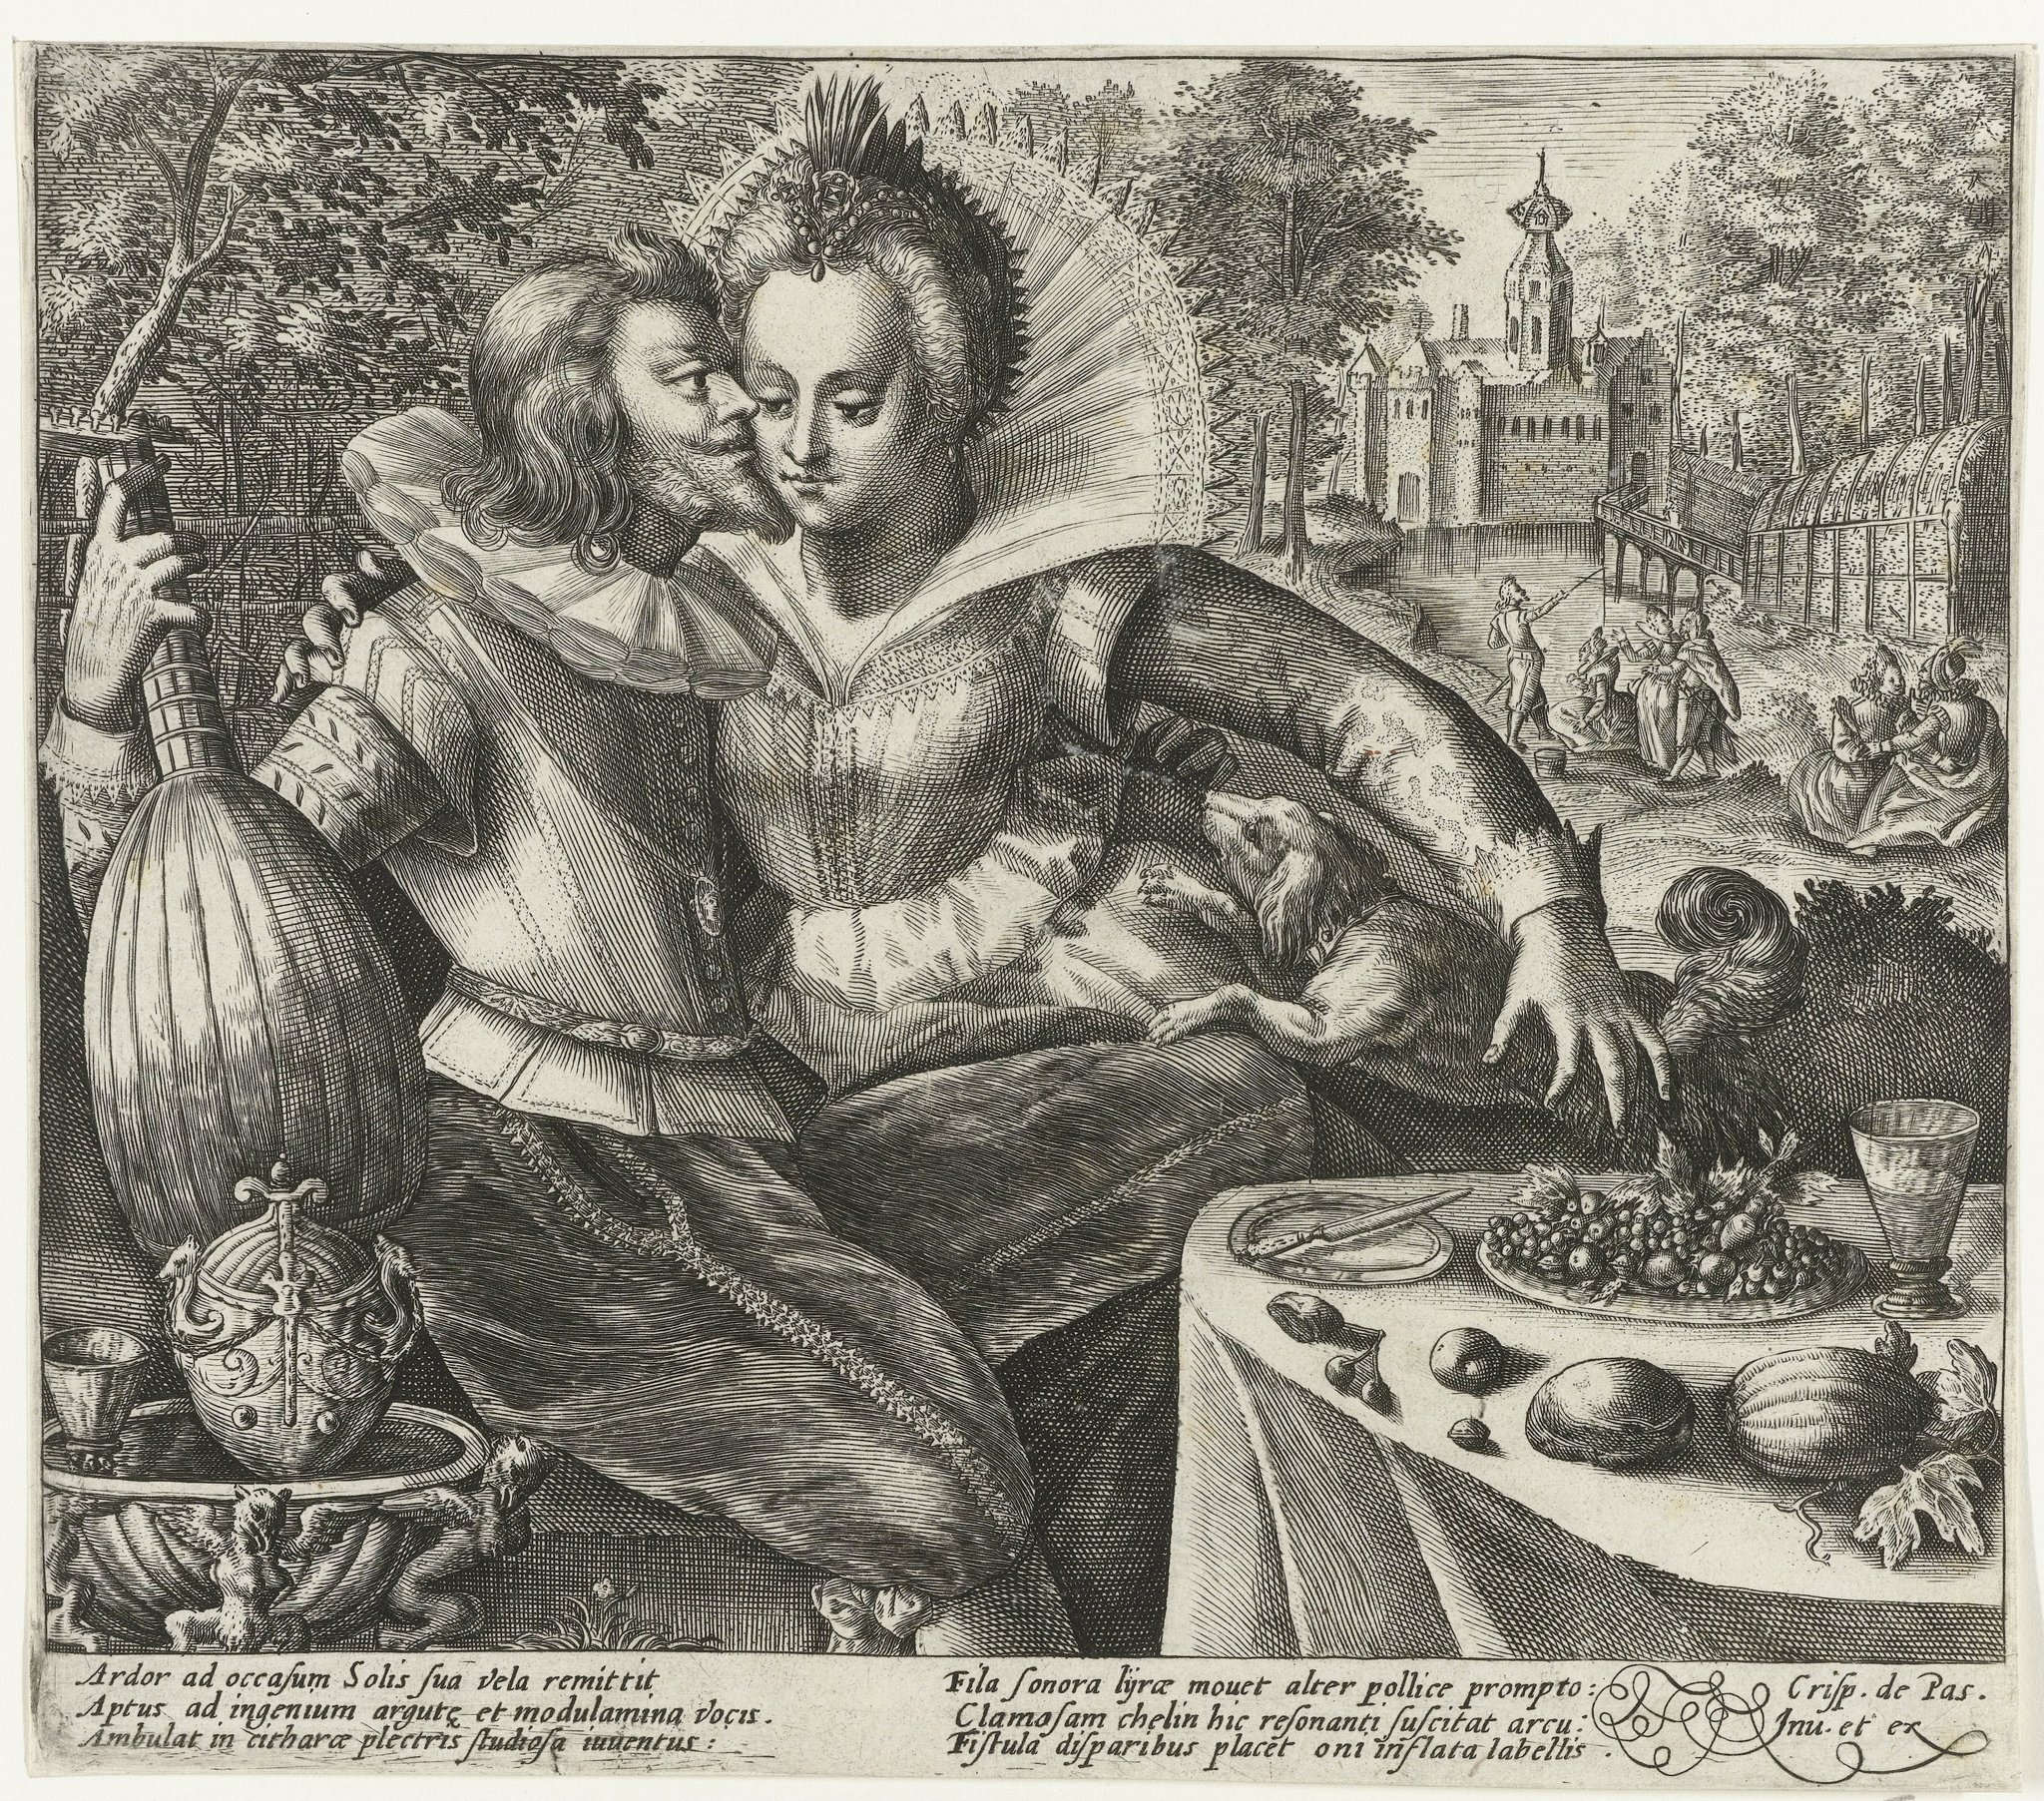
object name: print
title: Avond: minnend paar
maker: crispijn van de passe (i)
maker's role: draughtsman, print maker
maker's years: 1564-1637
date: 1574-1637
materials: paper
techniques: engraving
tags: ear-rings (+ women's clothes), personification of the evening, 'vesper', neck-gear ~ clothing (with name) (+ men's clothes), (lovers) embracing each other, 'symplegma', neck-gear: collar (+ women's clothes), sleeves: cuffs (+ women's clothes), dress, gown (+ women's clothes), lute, and special forms of lute, e.g.: theorbo, trousers, breeches, etc. (breeches) (+ men's clothes), clothing for the upper part of the body (doublet) (+ men's clothes), sleeves (+ women's clothes), clothing for the upper part of the body (with name) (+ women's clothes), laid table: table-ware, table-decoration, etc., netherlands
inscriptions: collector's mark: Lugt 2228, collector's mark: Lugt 2542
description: De Avond: prieel met een elegant gekleed paar dat elkaar omhelst. De man houdt een luit in de hand. Een hond springt tegen de vrouw op. Op de achtergrond een kasteeltuin met een elegant gezelschap. In de marge een zesregelig onderschrift, in twee kolommen, in het Latijn dat verwijst naar de avond.